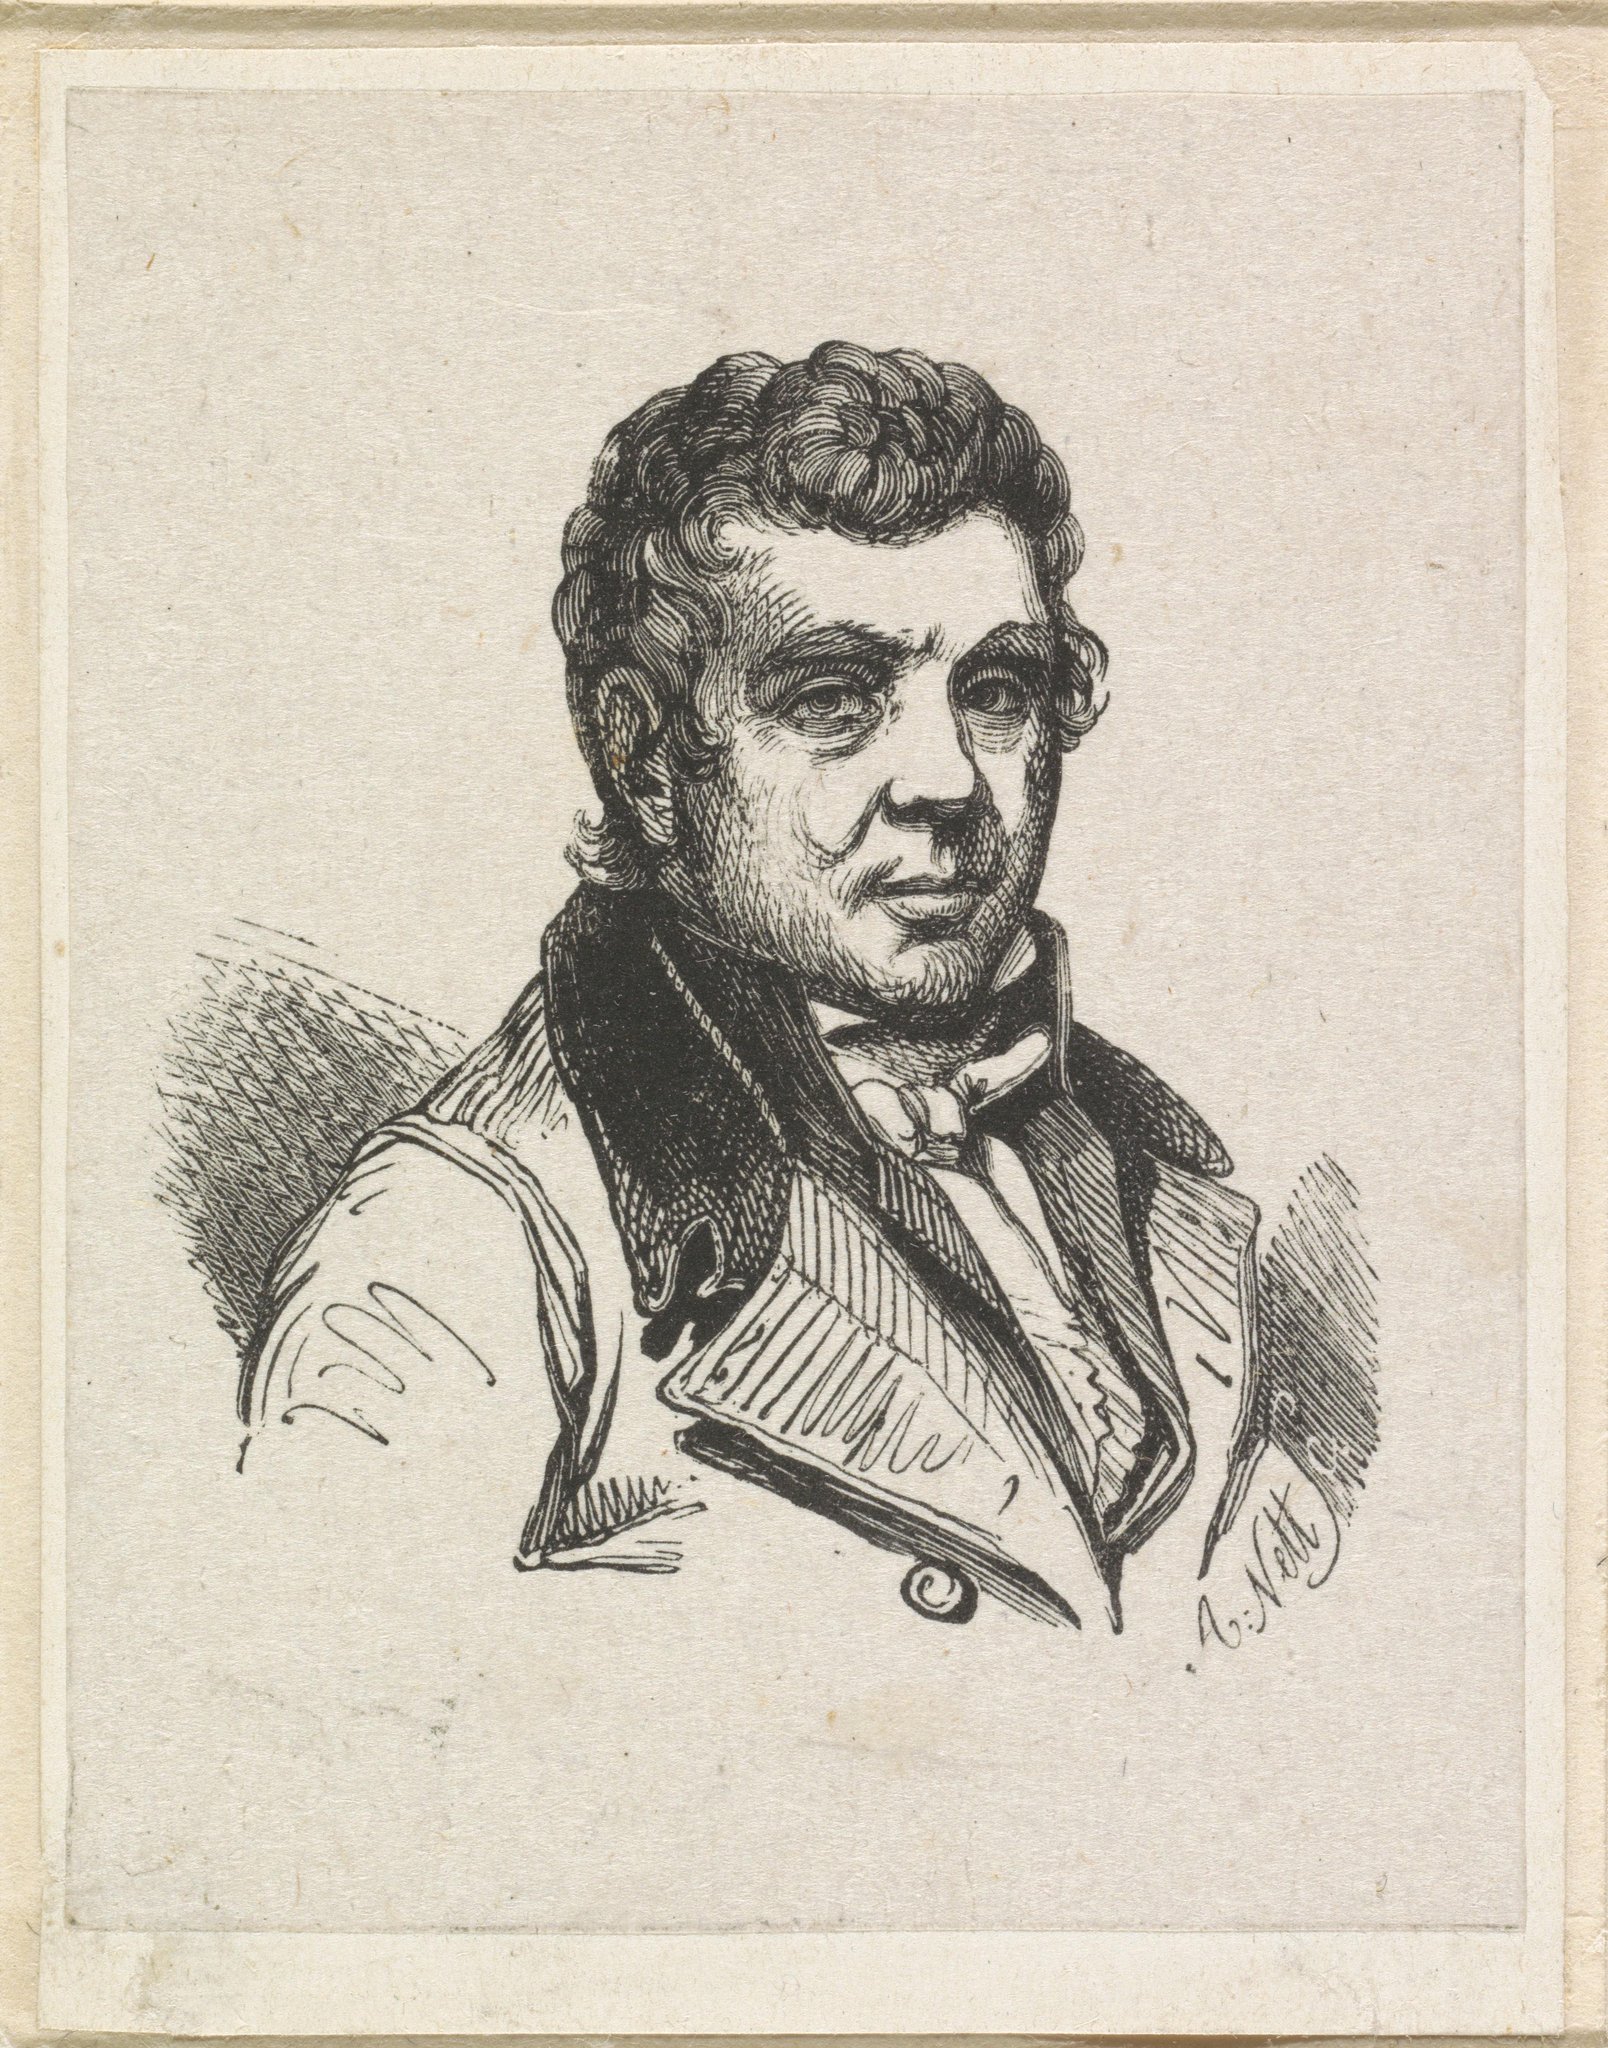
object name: print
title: Portret van Willem Bartel van der Kooi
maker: adolphe frédéric nett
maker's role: print maker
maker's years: 1822-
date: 1832-1900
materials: paper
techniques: engraving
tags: painter, print maker, draughtsman, willem bartel van der kooi, historical persons, portrait, self-portrait of artist